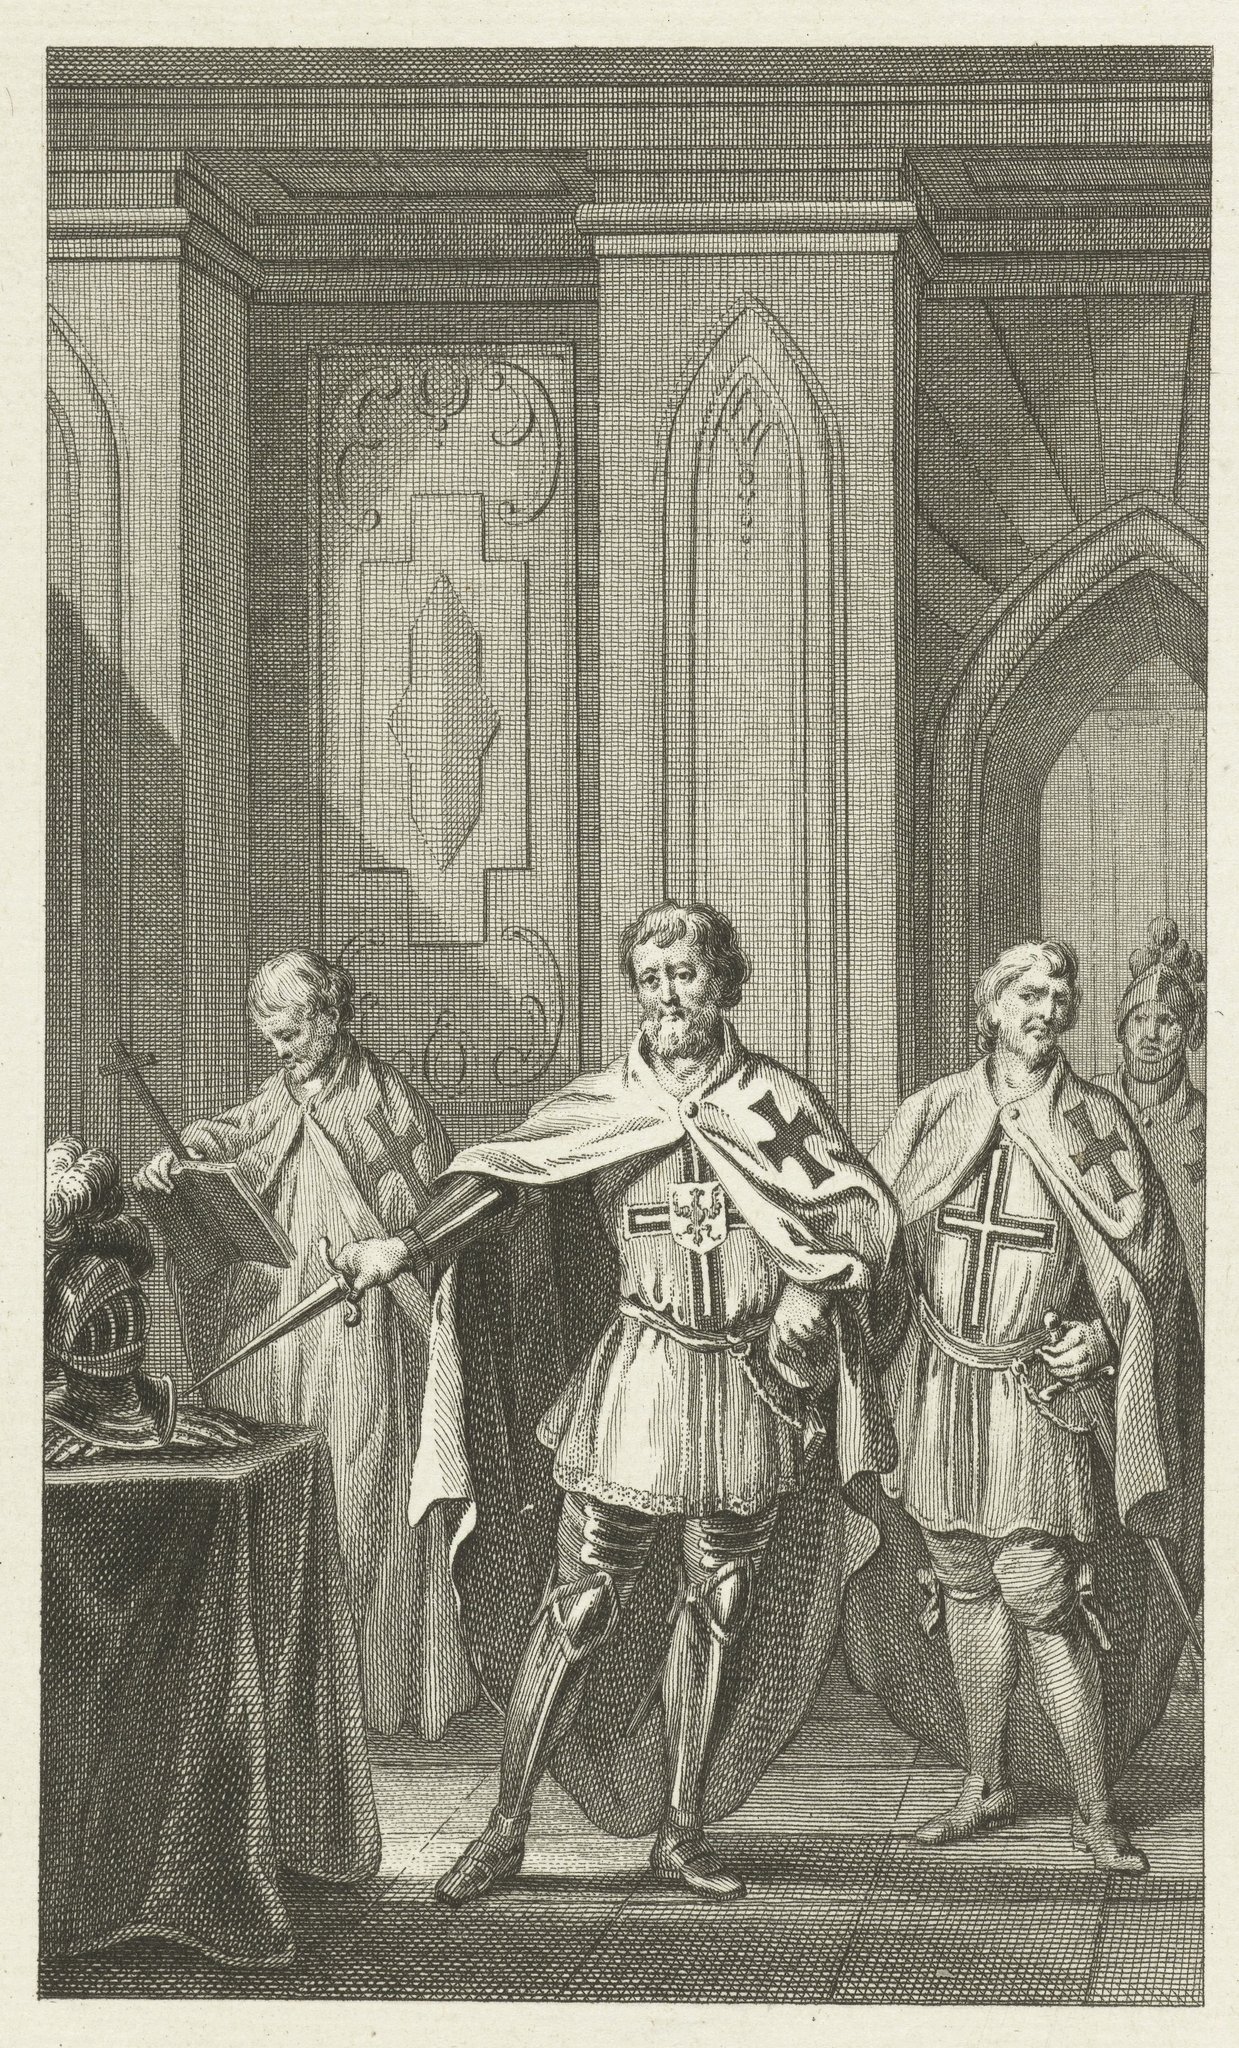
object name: history print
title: Ridders van het Duitsche Huis, 1180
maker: reinier vinkeles (i)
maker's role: draughtsman, print maker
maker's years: 1741-1816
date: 1783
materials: paper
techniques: etching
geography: netherlands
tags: knighthood order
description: Illustratie uit: Jacobus Kok, Vaderlandsch Woordenboek, Johannes Allart, Amsterdam 1785-1799, 35 delen, dl. XIII, pl. I. Staat vóór de letter.